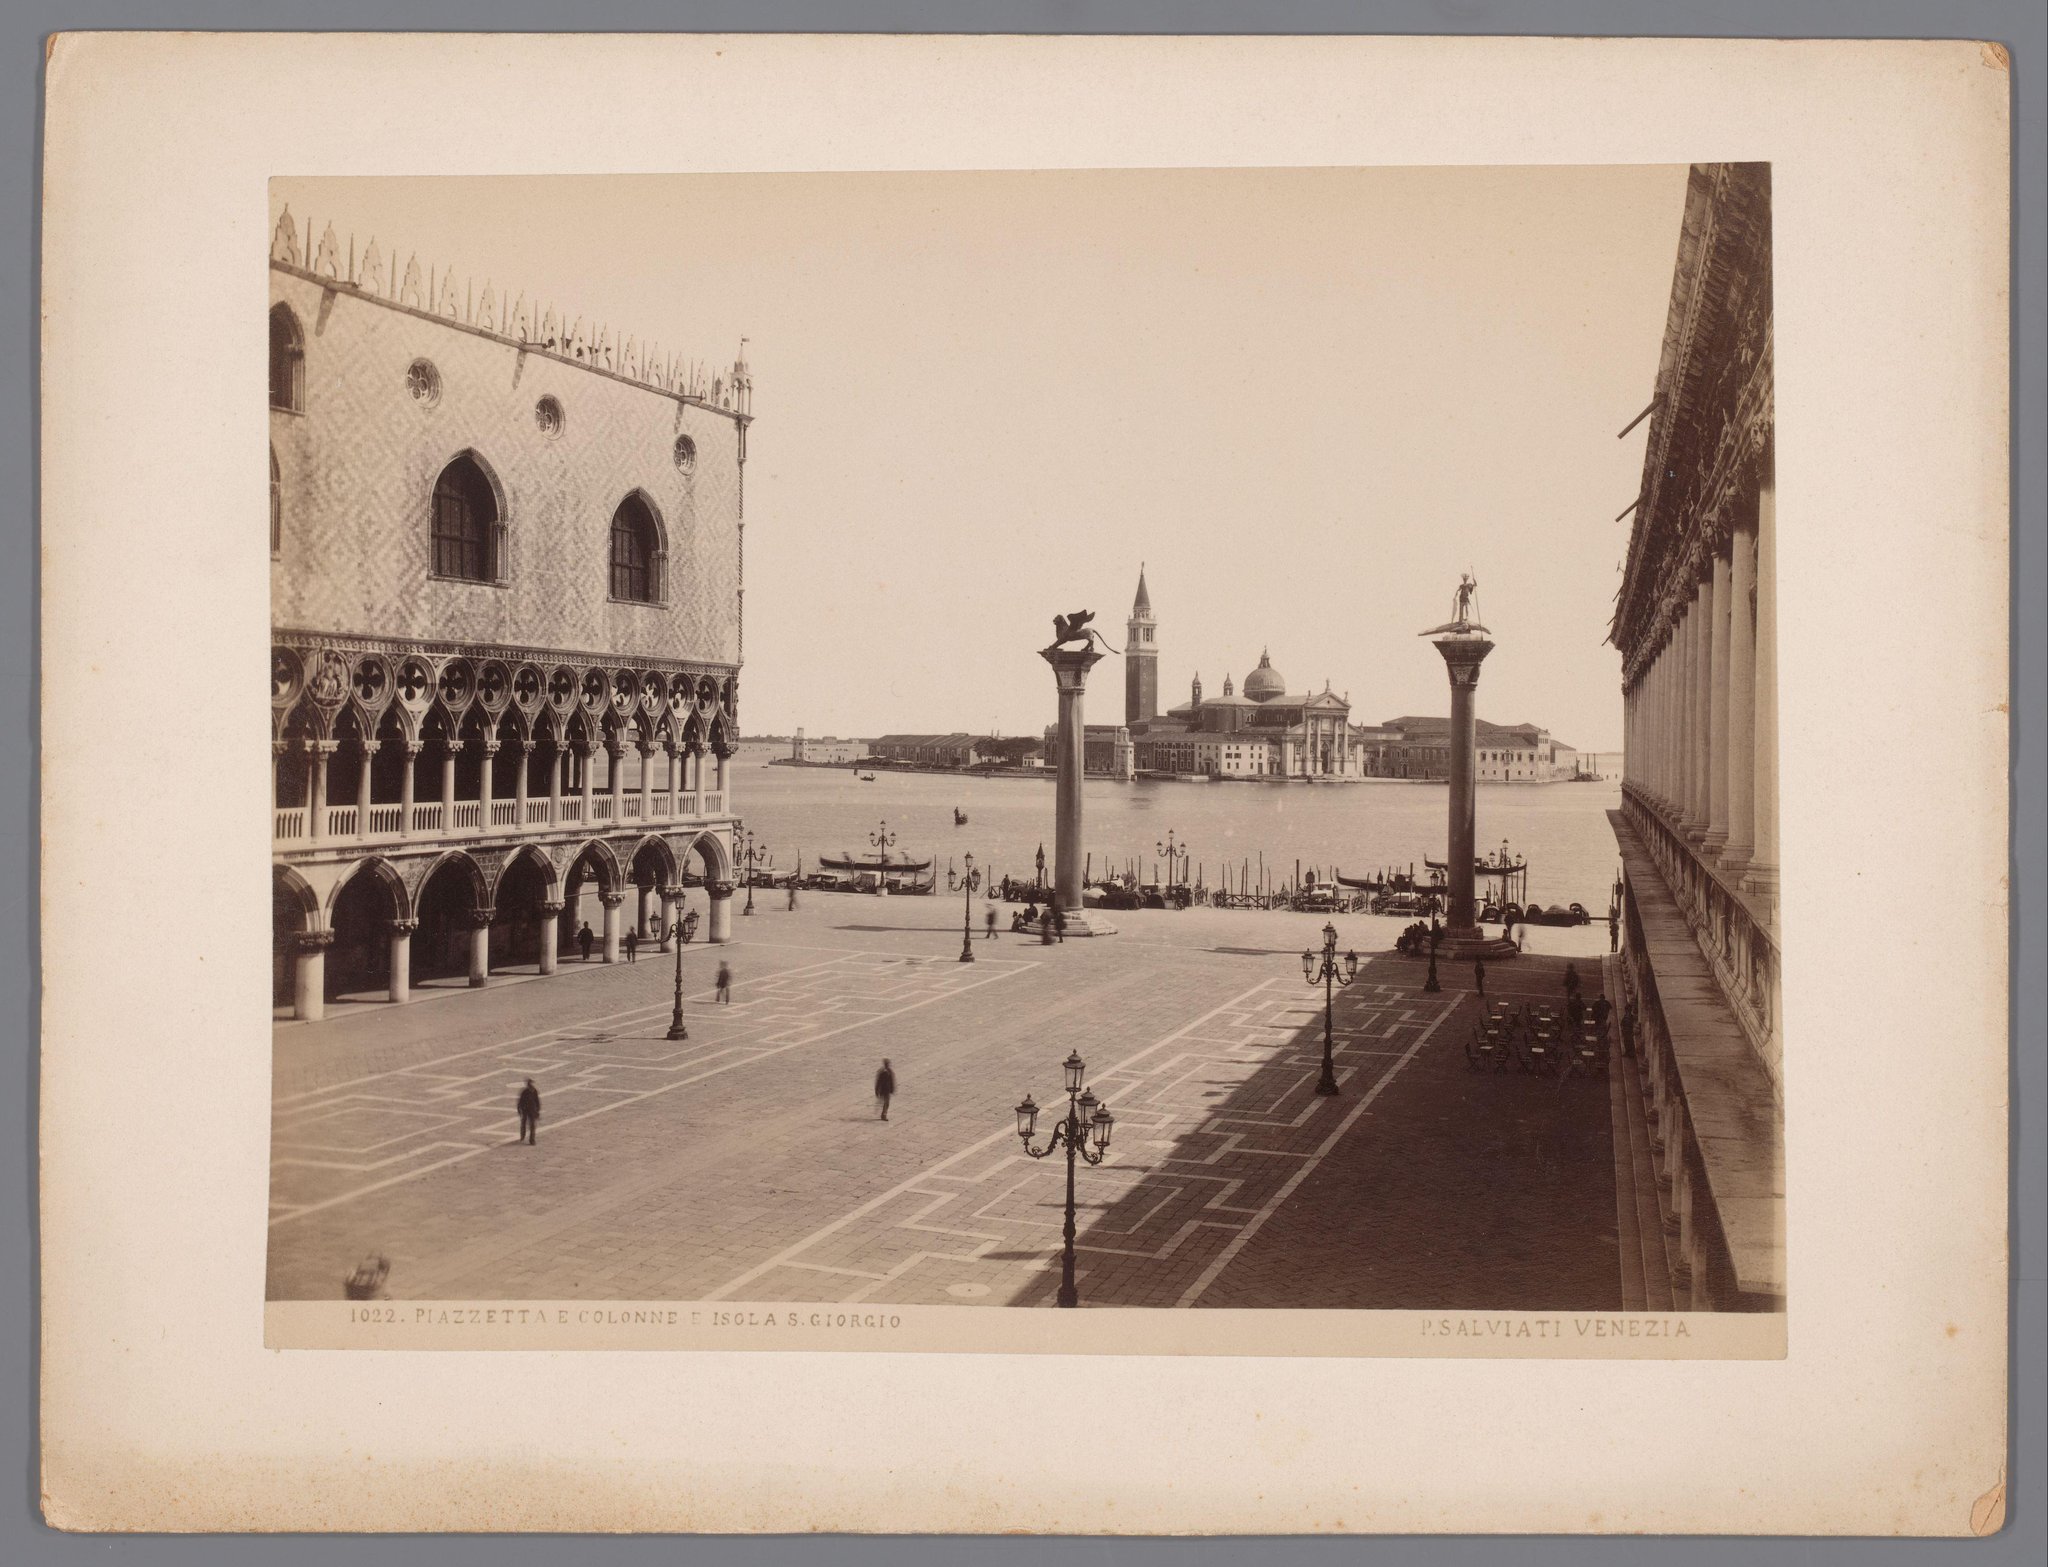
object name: photograph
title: Piazzetta e Colonne e Isola S. Giorgio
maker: paolo salviati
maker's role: fotograaf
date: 1860-1870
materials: cardboard, paper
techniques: albumen print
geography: venice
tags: square, place, circus, etc., column, pillar ~ architecture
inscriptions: number: ‘1022.’